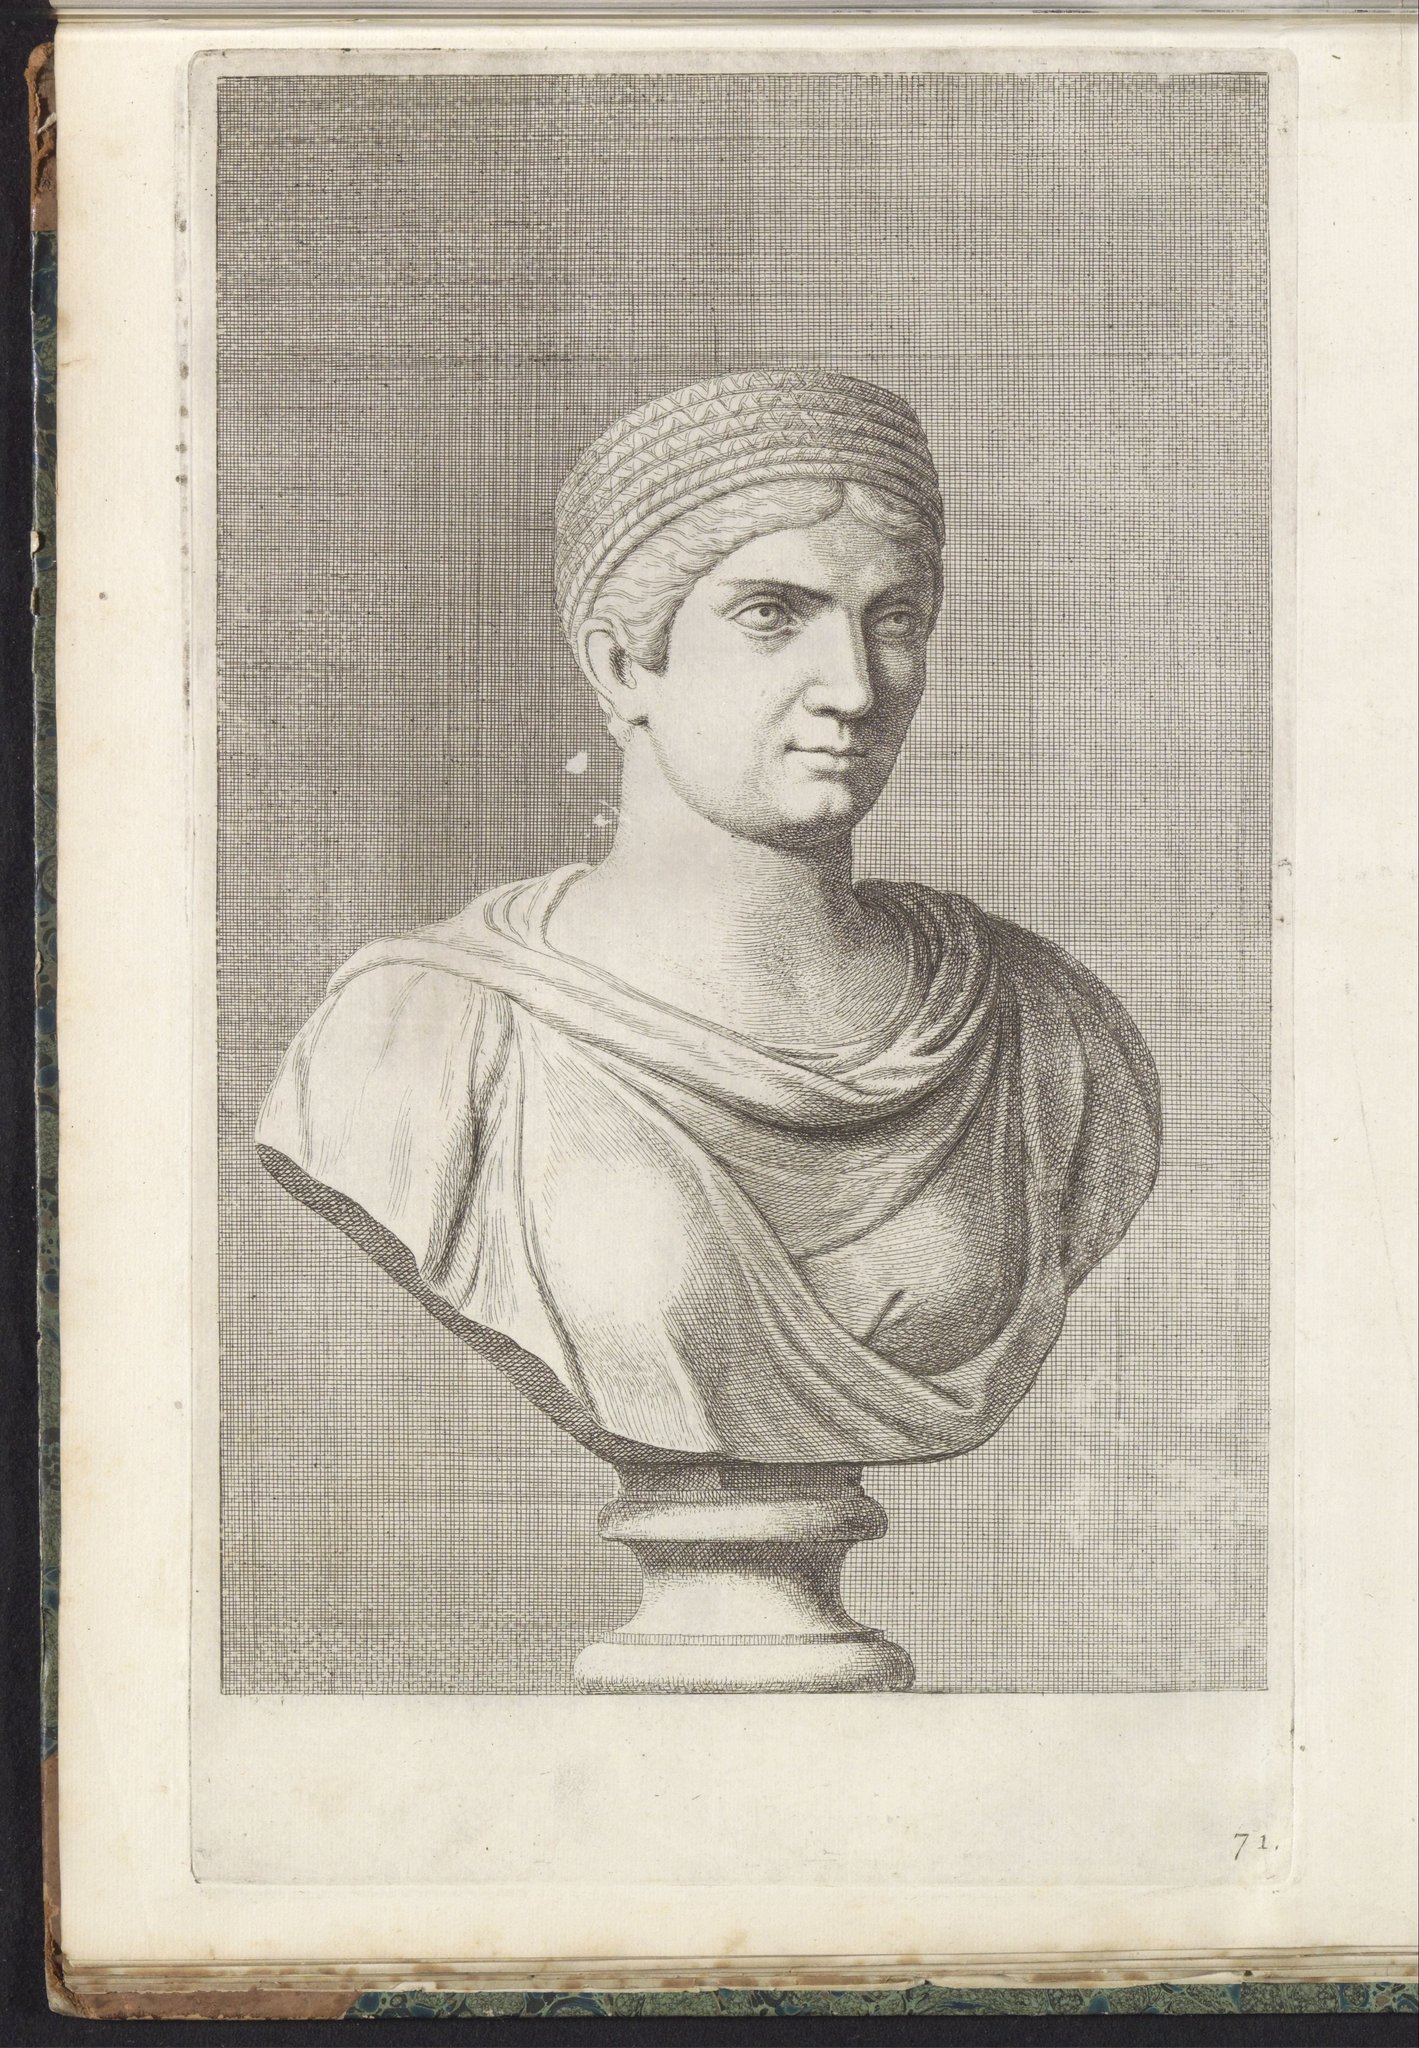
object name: album leaf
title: Buste van een vrouw met hoofddeksel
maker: hubert quellinus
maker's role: print maker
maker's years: 1619-1687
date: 1646-1670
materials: paper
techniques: engraving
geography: antwerp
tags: piece of sculpture, reproduction of a piece of sculpture, female persons from classical history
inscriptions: number: ‘75’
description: De prent maakt deel uit van een album met een serie prenten naar de sculpturen in de verzameling van Gerard Reynst.